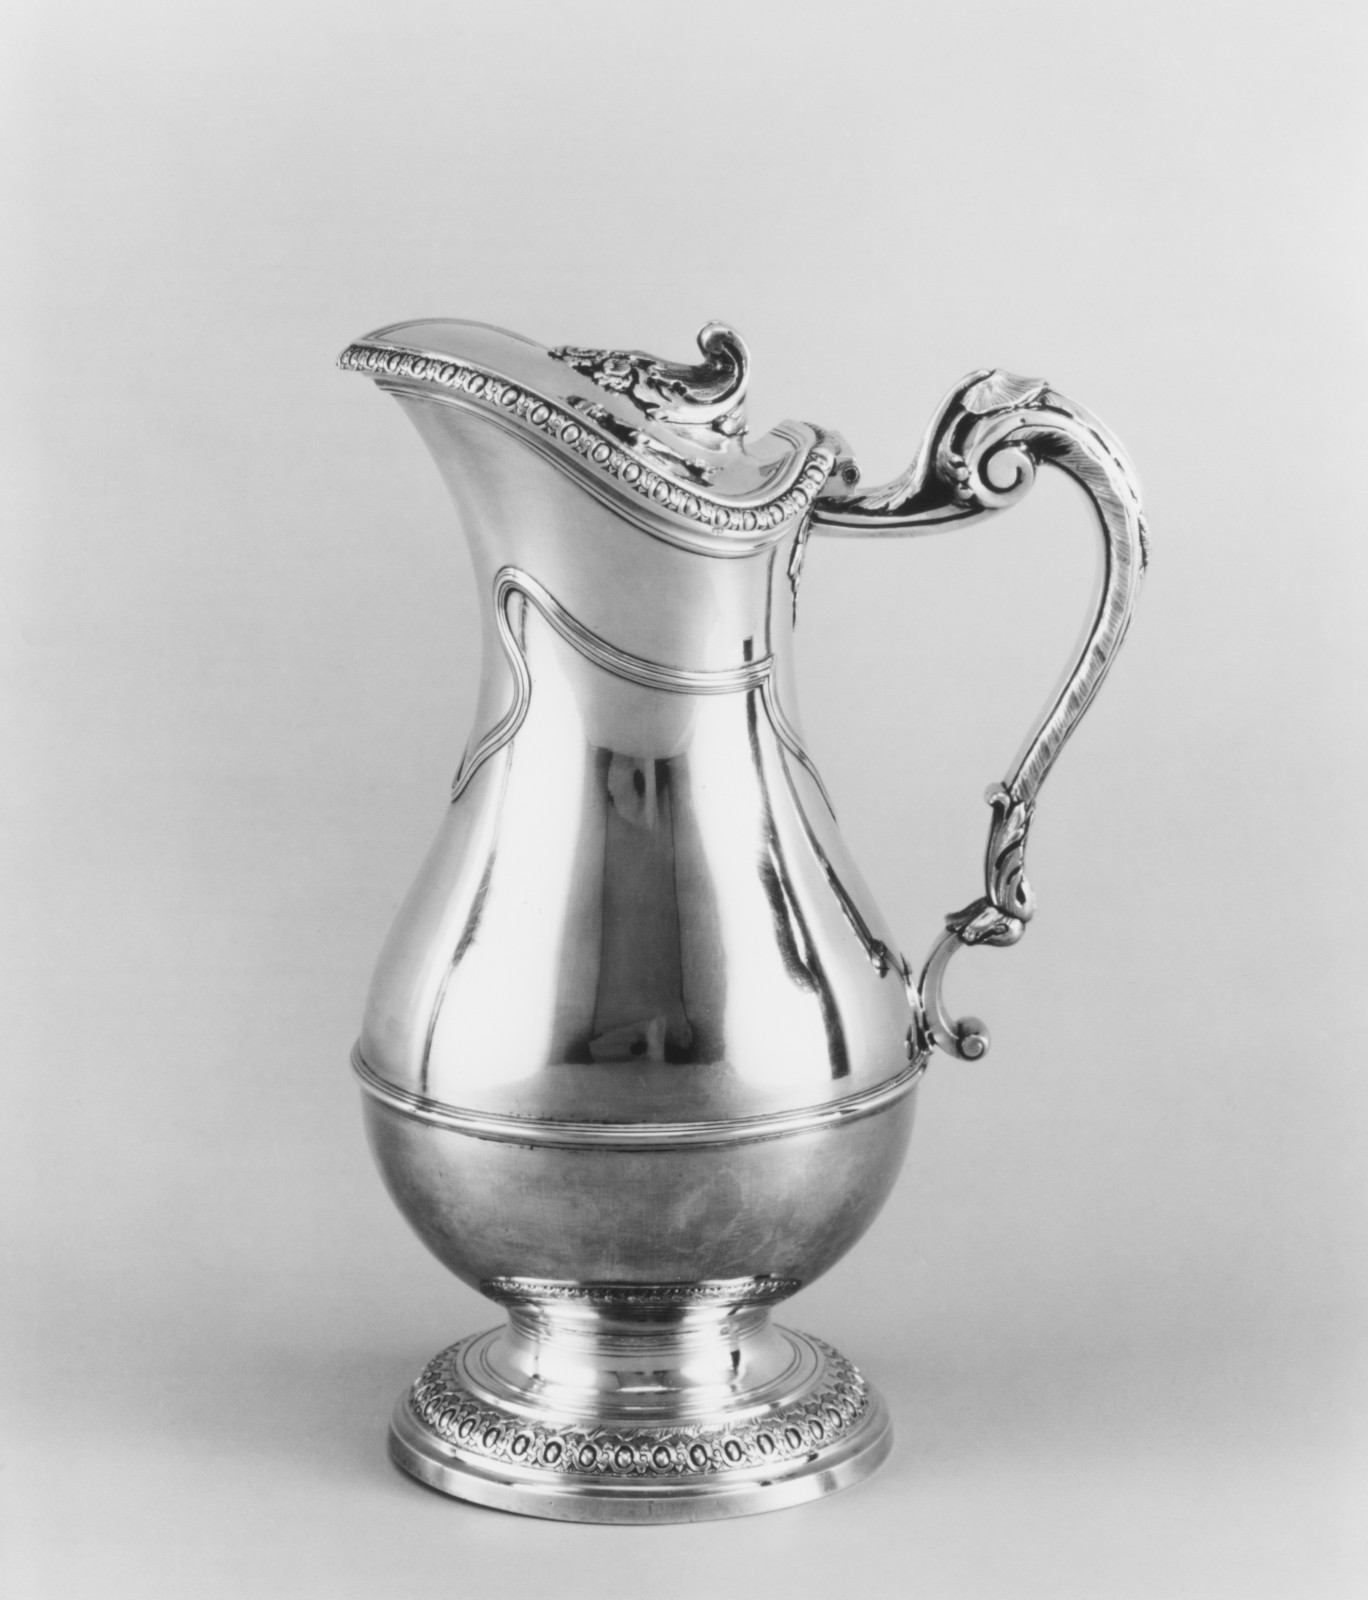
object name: ewer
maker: françois joubert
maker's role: maker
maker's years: 1719-1823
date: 1753-1754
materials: silver